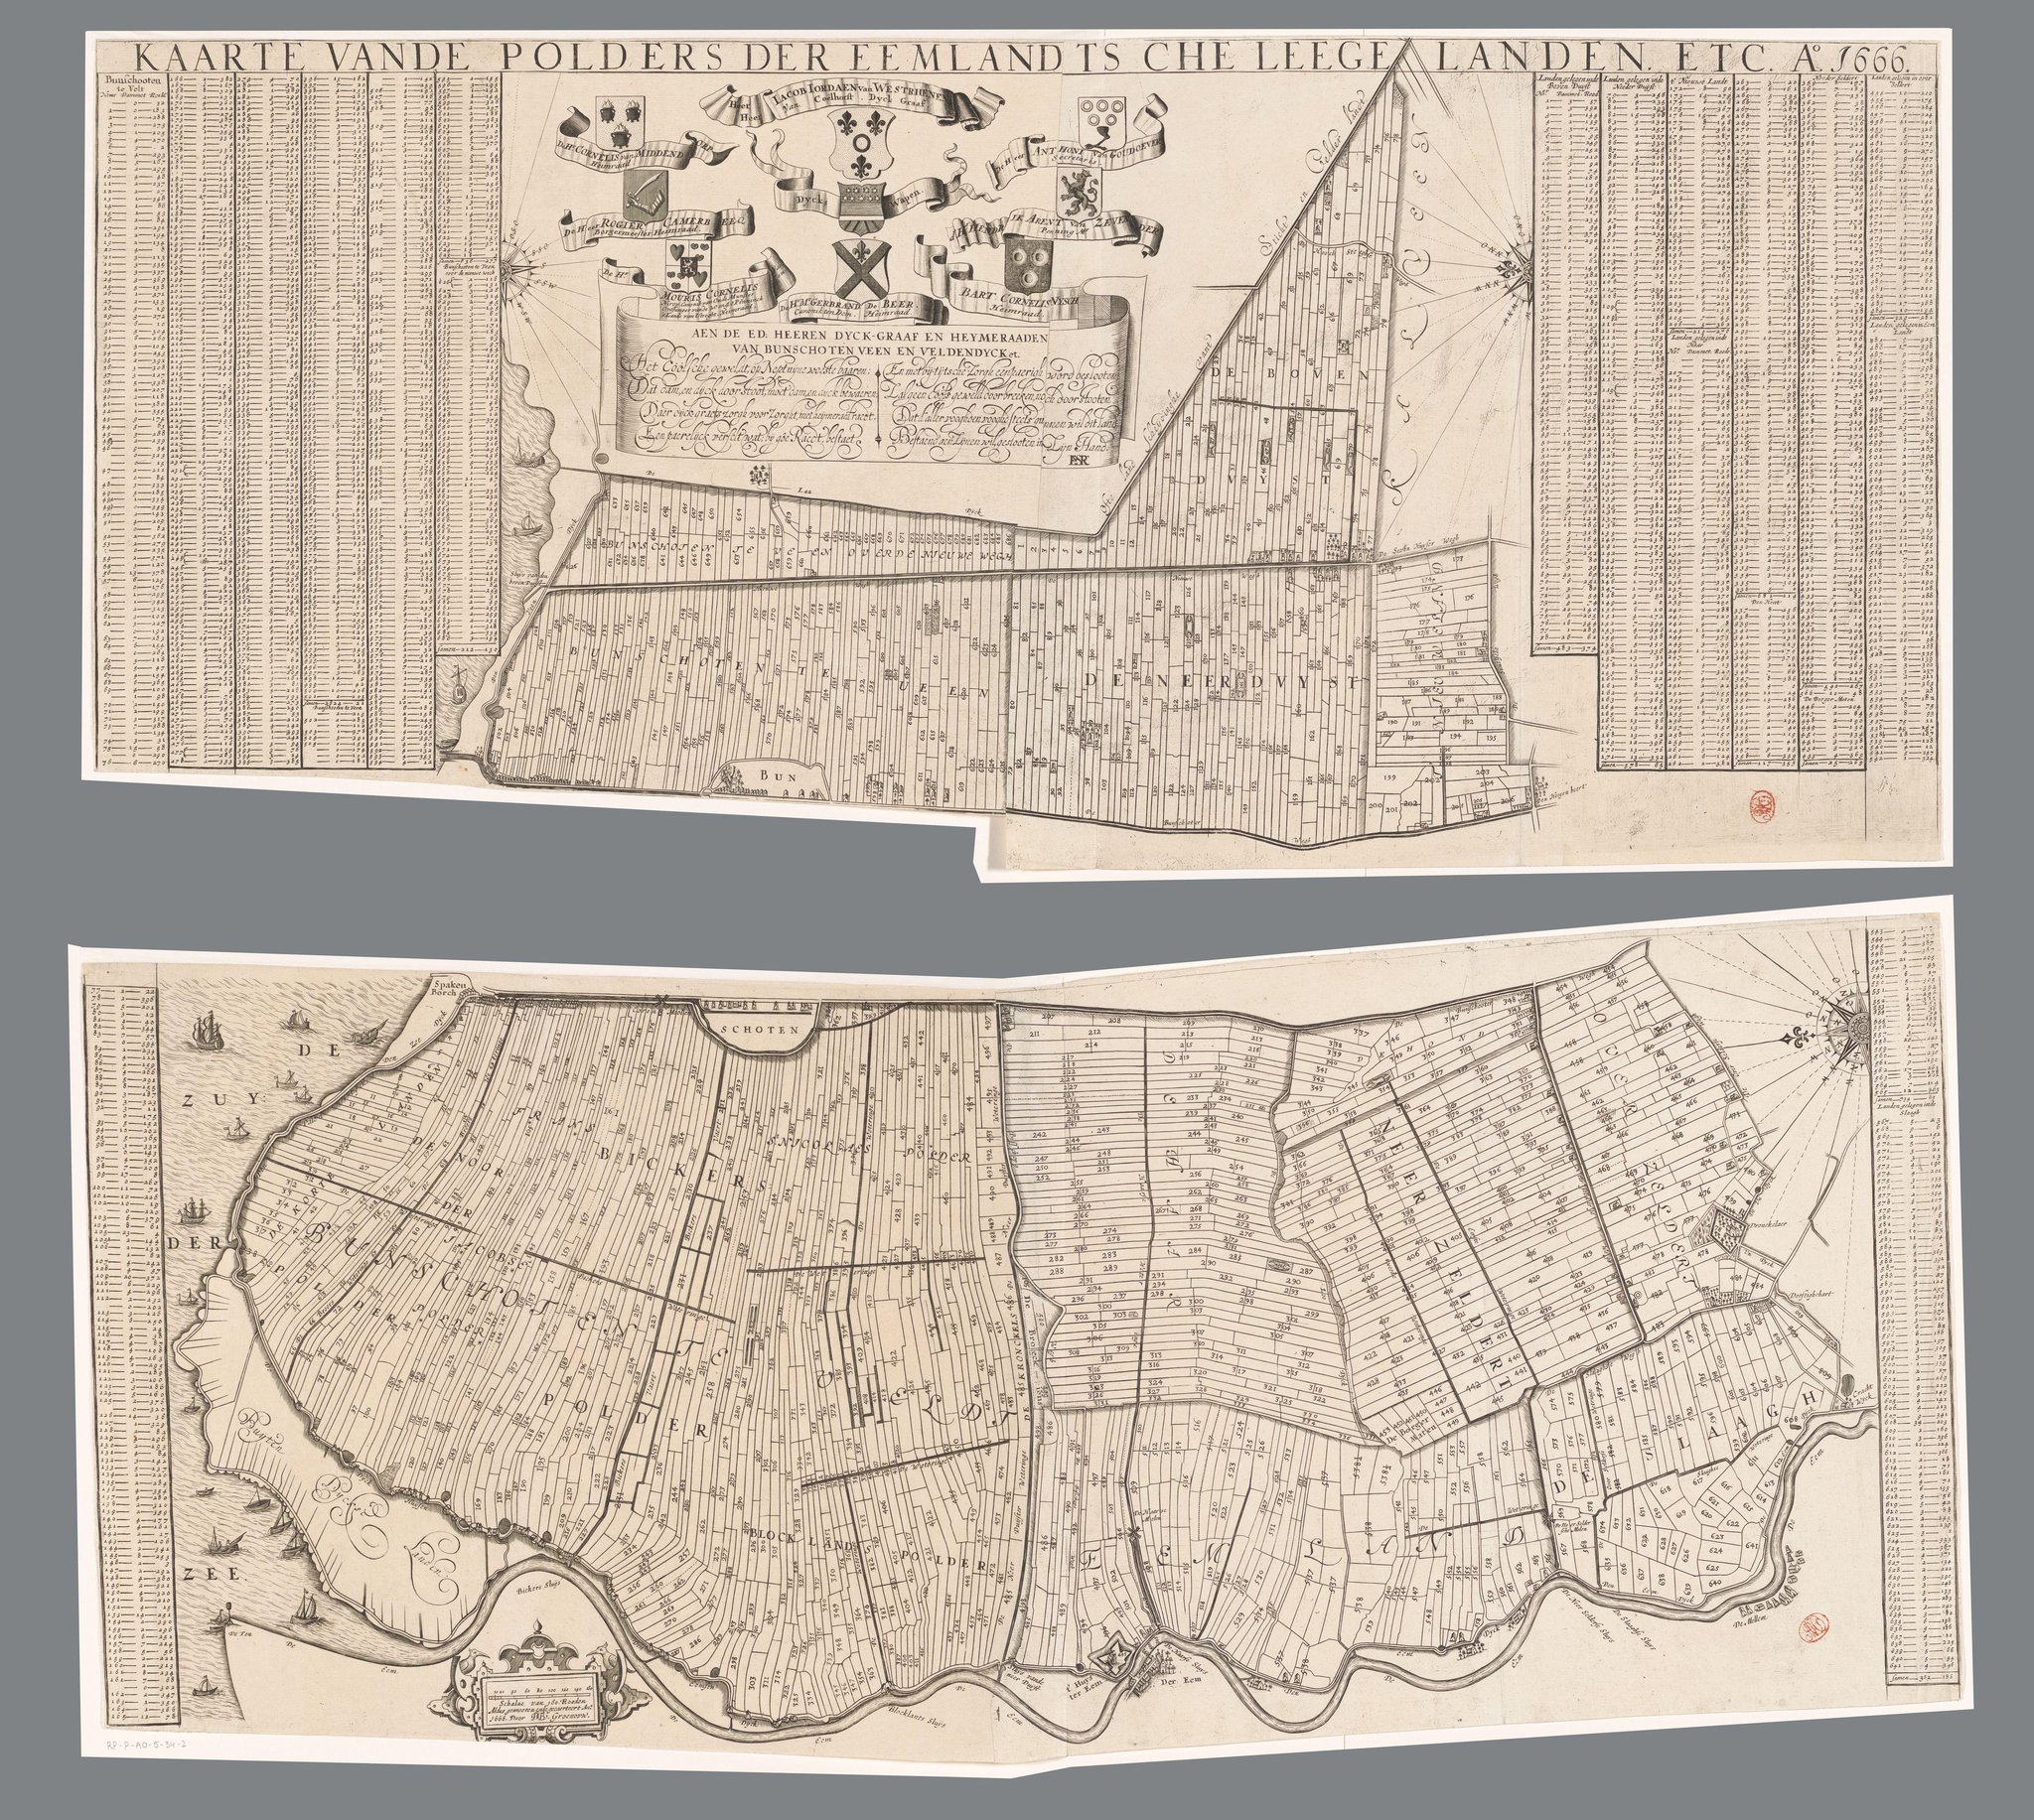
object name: map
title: Polderkaart van Eemland, bestaande uit twee delen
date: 1666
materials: paper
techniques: engraving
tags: coat of arms (as symbol of the state, etc.), maps of separate countries or regions, polder, reclaimed land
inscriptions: collector's mark: Lugt 195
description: Langs de bovenkant de titel met daaronder de wapens van de leden van het Hoogheemraadschap van den Bunschoter Veen- en Veldendijk, daaronder de opdracht met een gedicht. De percelen op de kaart zijn genummerd, de bijhorende oppervlaktes staan in de legenda links en recht van de kaart. Linksonder een schaalstok: Schalae van 160 roeden.